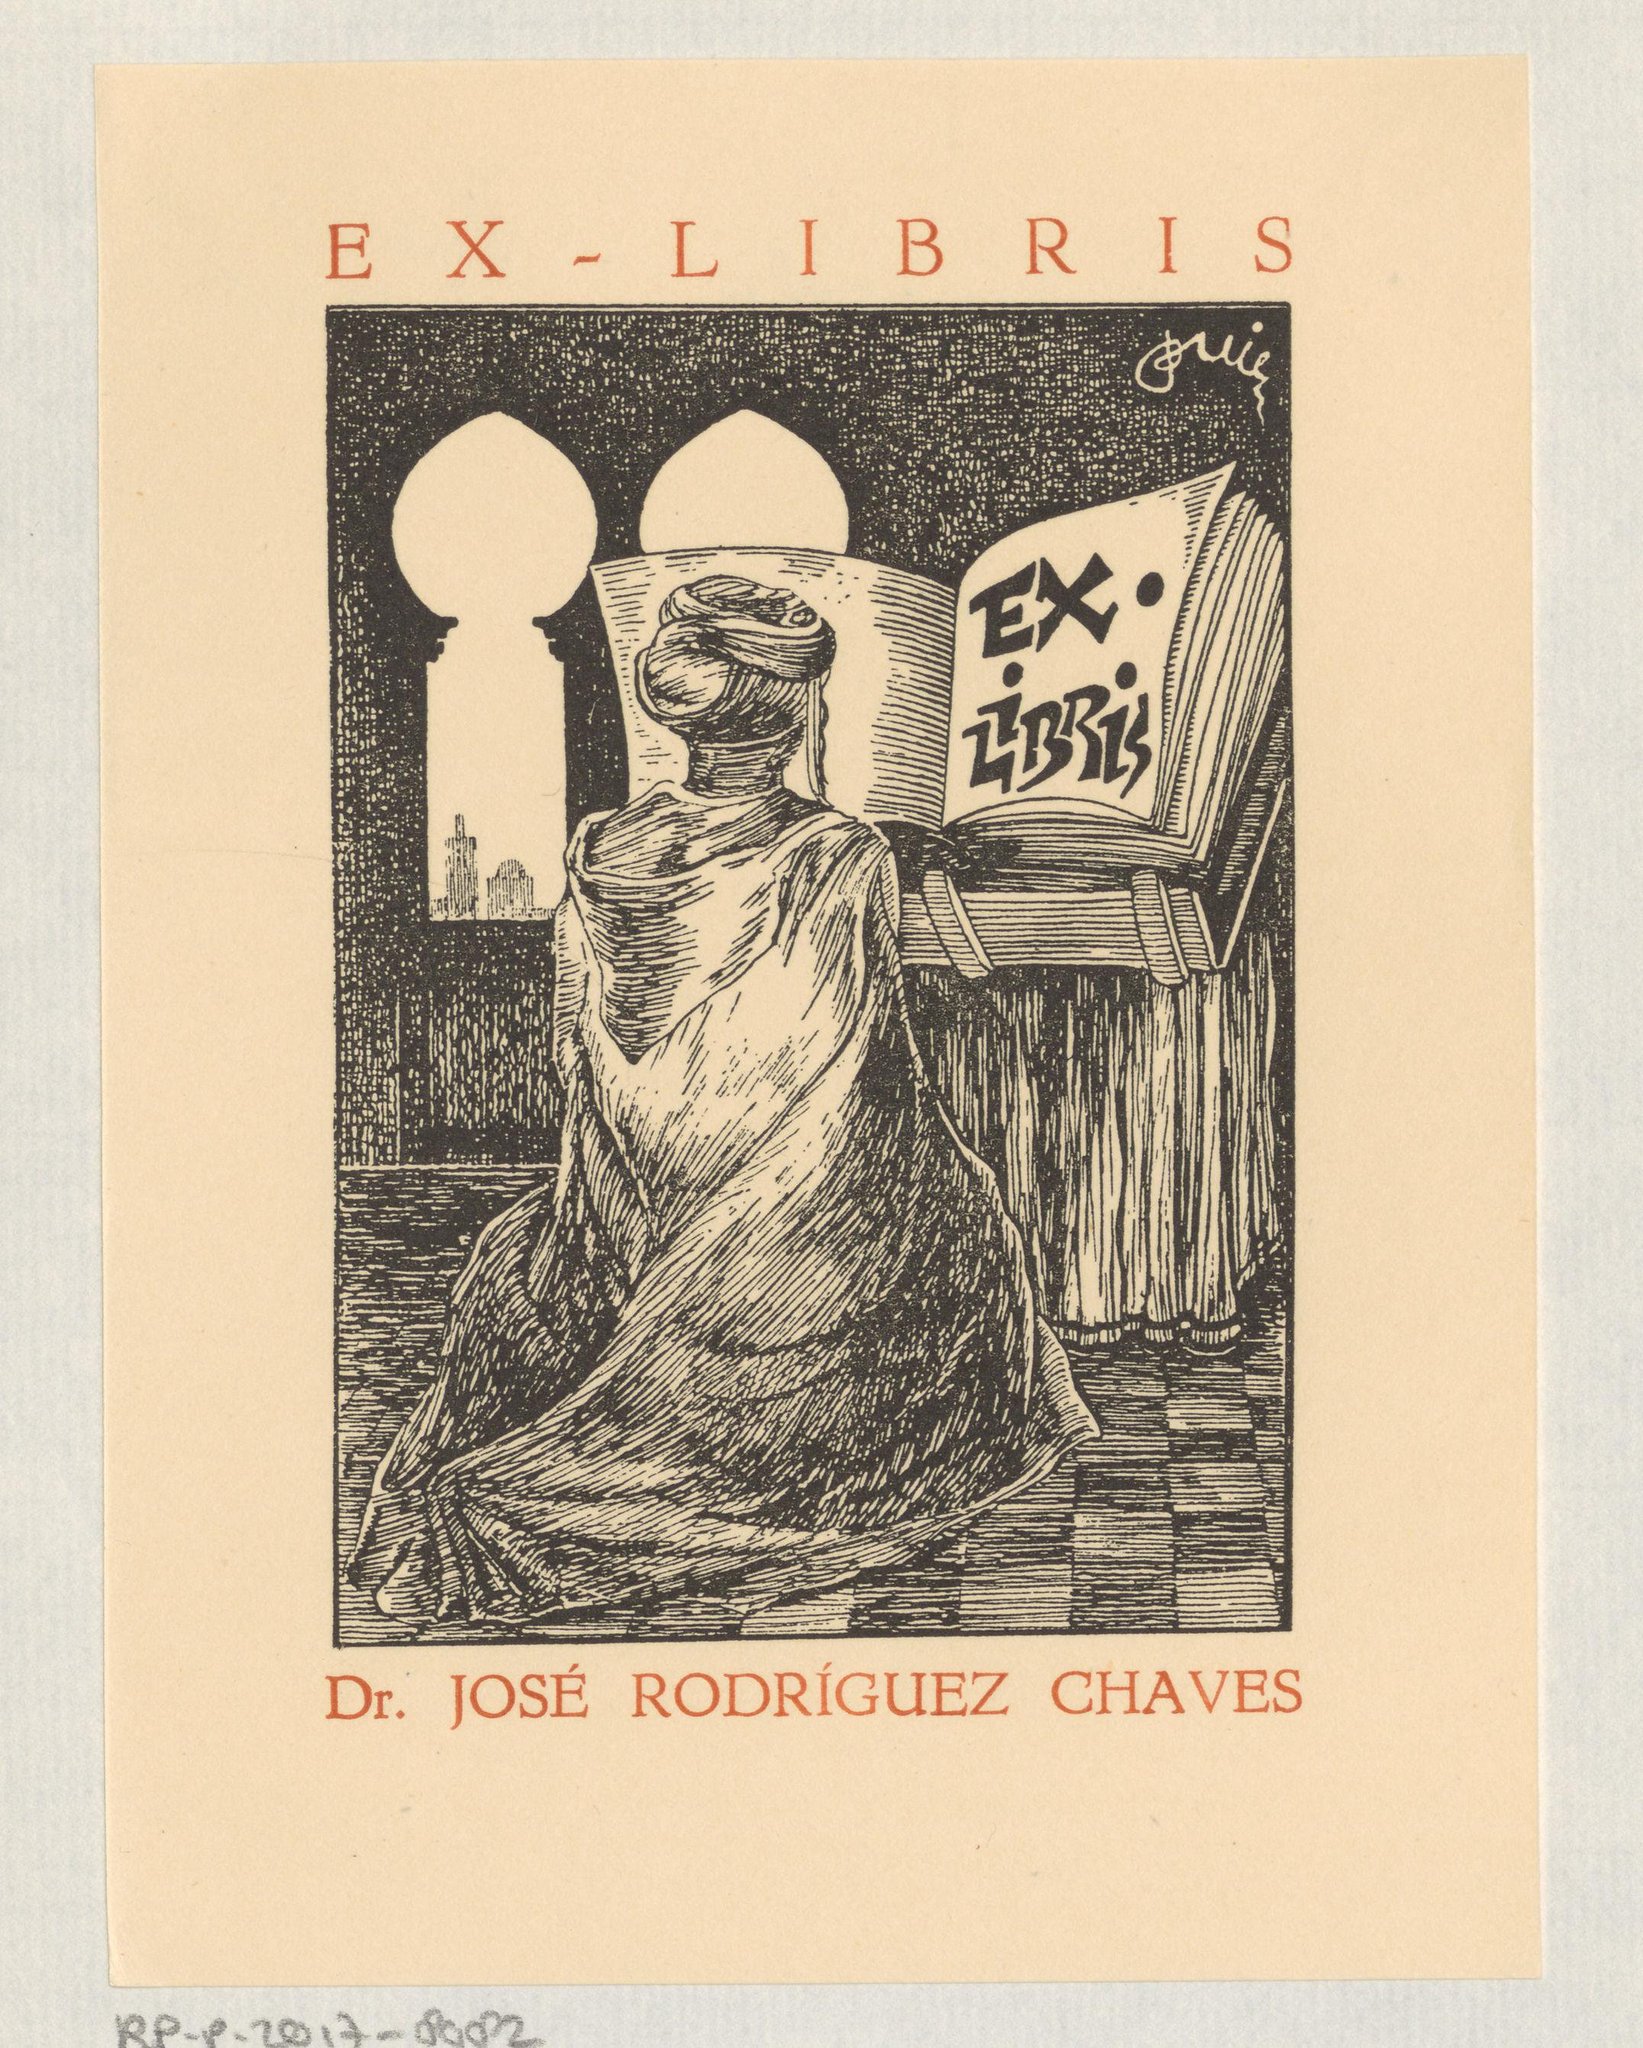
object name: bookplate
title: Ex-libris Dr. José Rodríguez Chaves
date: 1945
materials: paper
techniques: printing block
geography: spain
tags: josé rodriguez chaves, reading, head-gear: turban, book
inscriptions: inscription: ‘Junceda Spanien/ 1945’